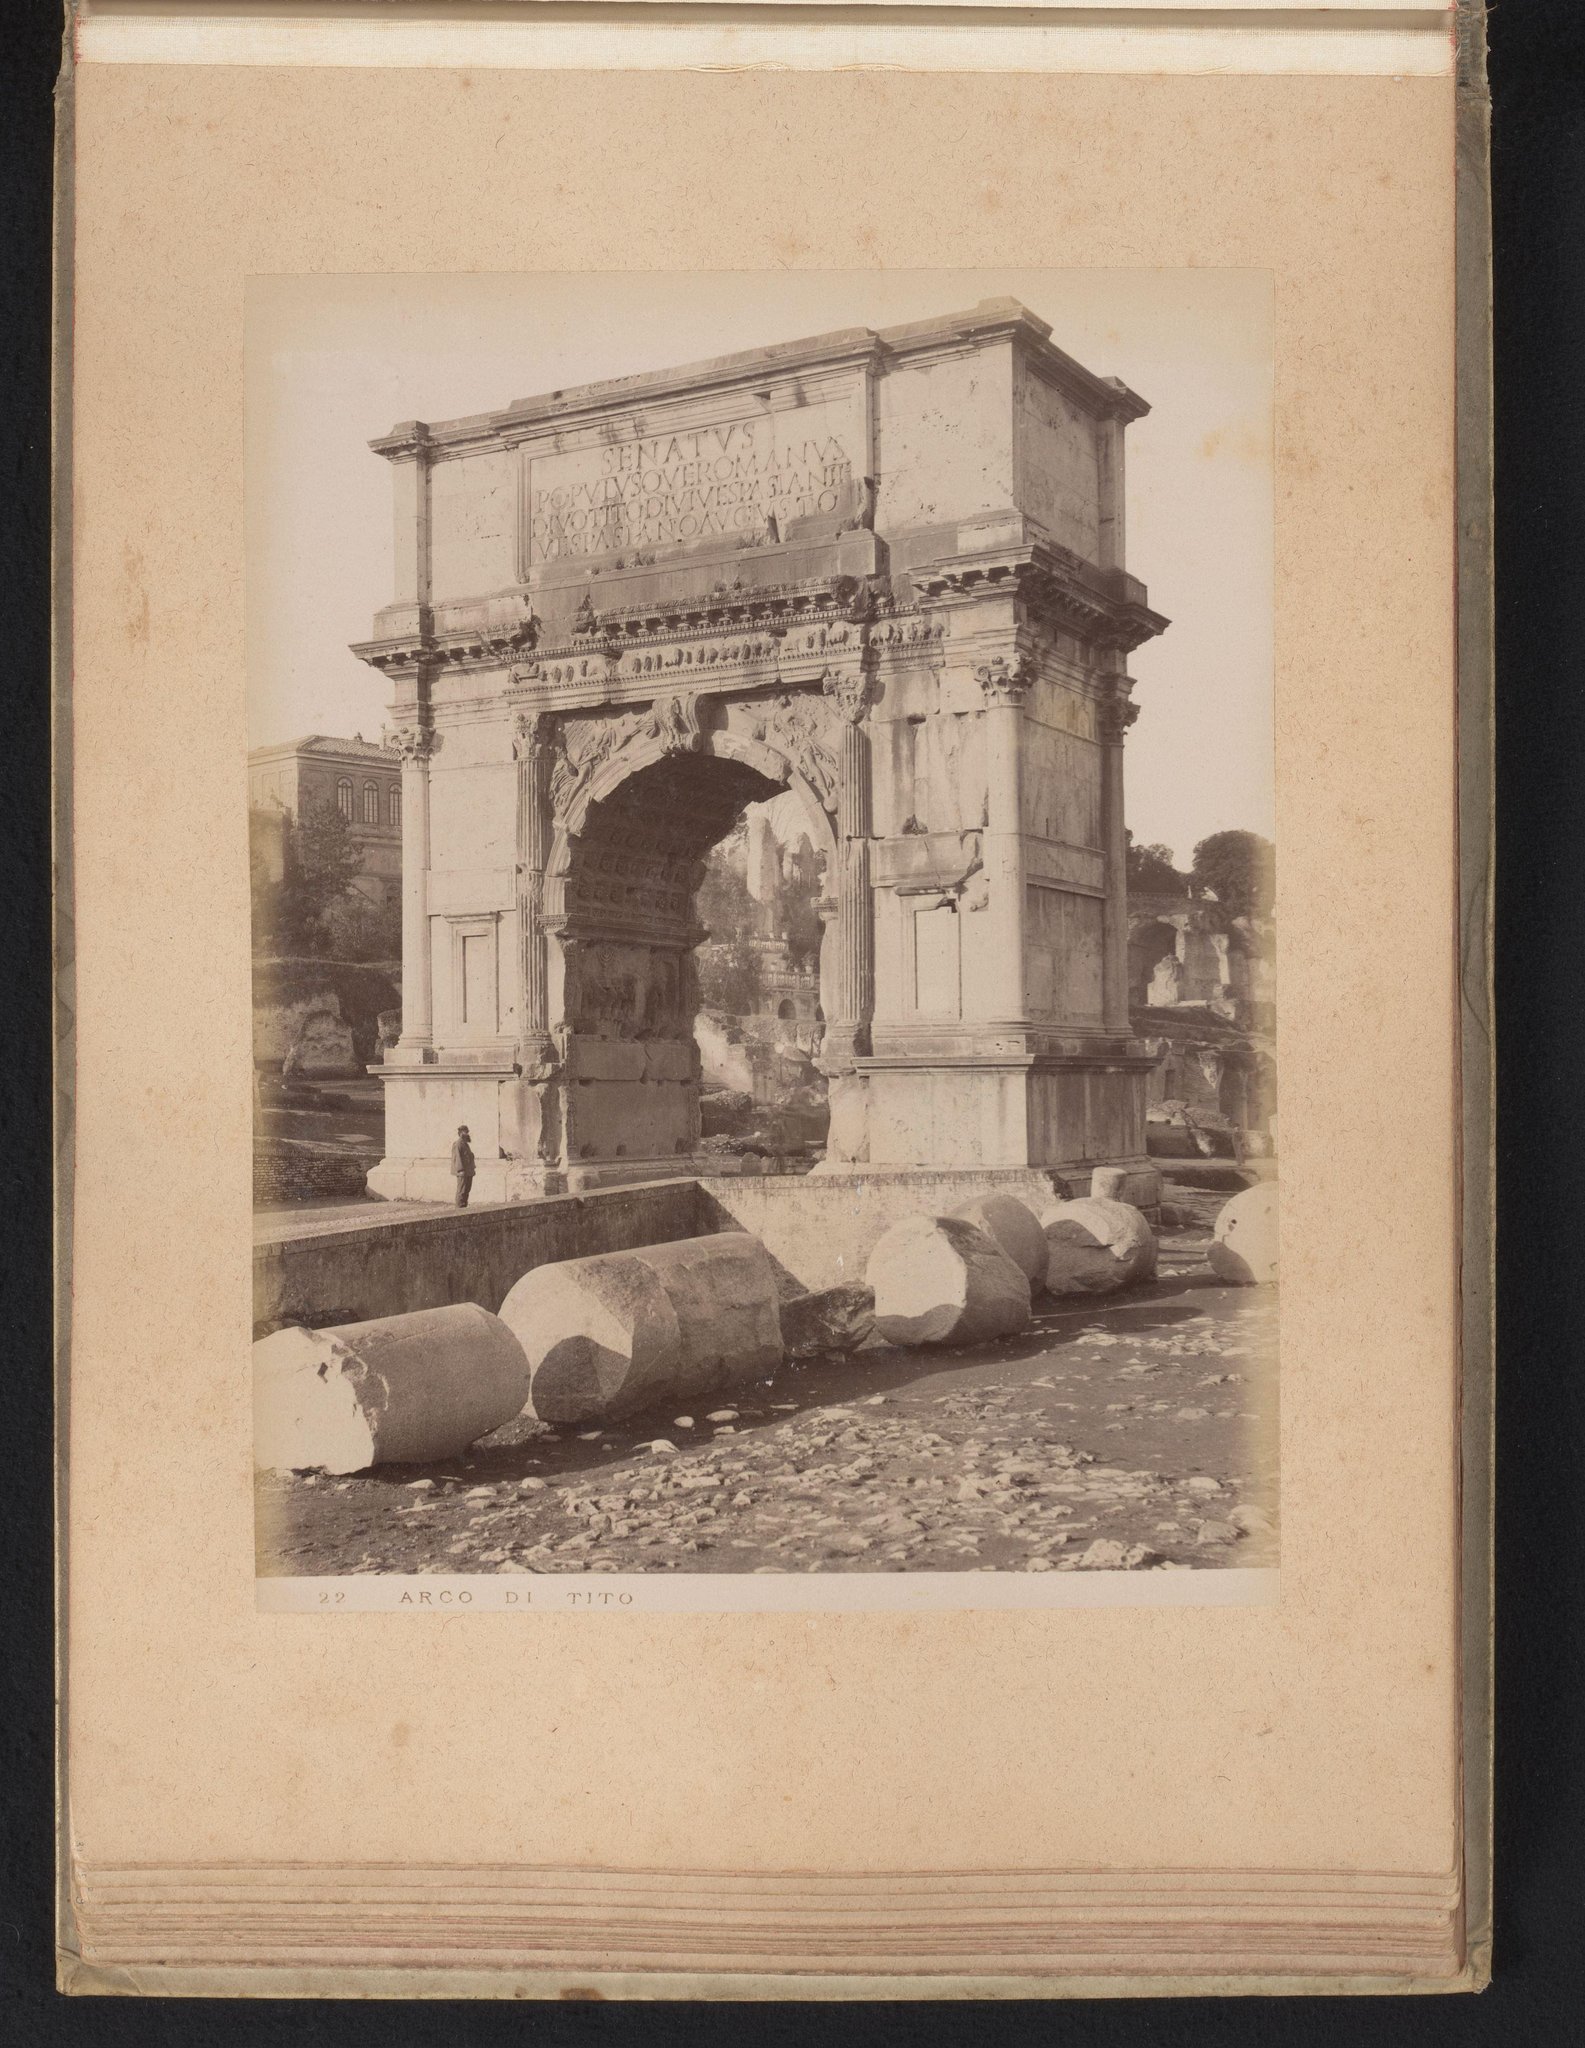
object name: photograph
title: Gezicht op de Boog van Titus op het Forum Romanum in Rome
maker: Anonymous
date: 1870-1895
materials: cardboard, photographic support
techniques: albumen print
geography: rome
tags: triumphal arch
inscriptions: inscription: ‘22 ARCO DI TITO’